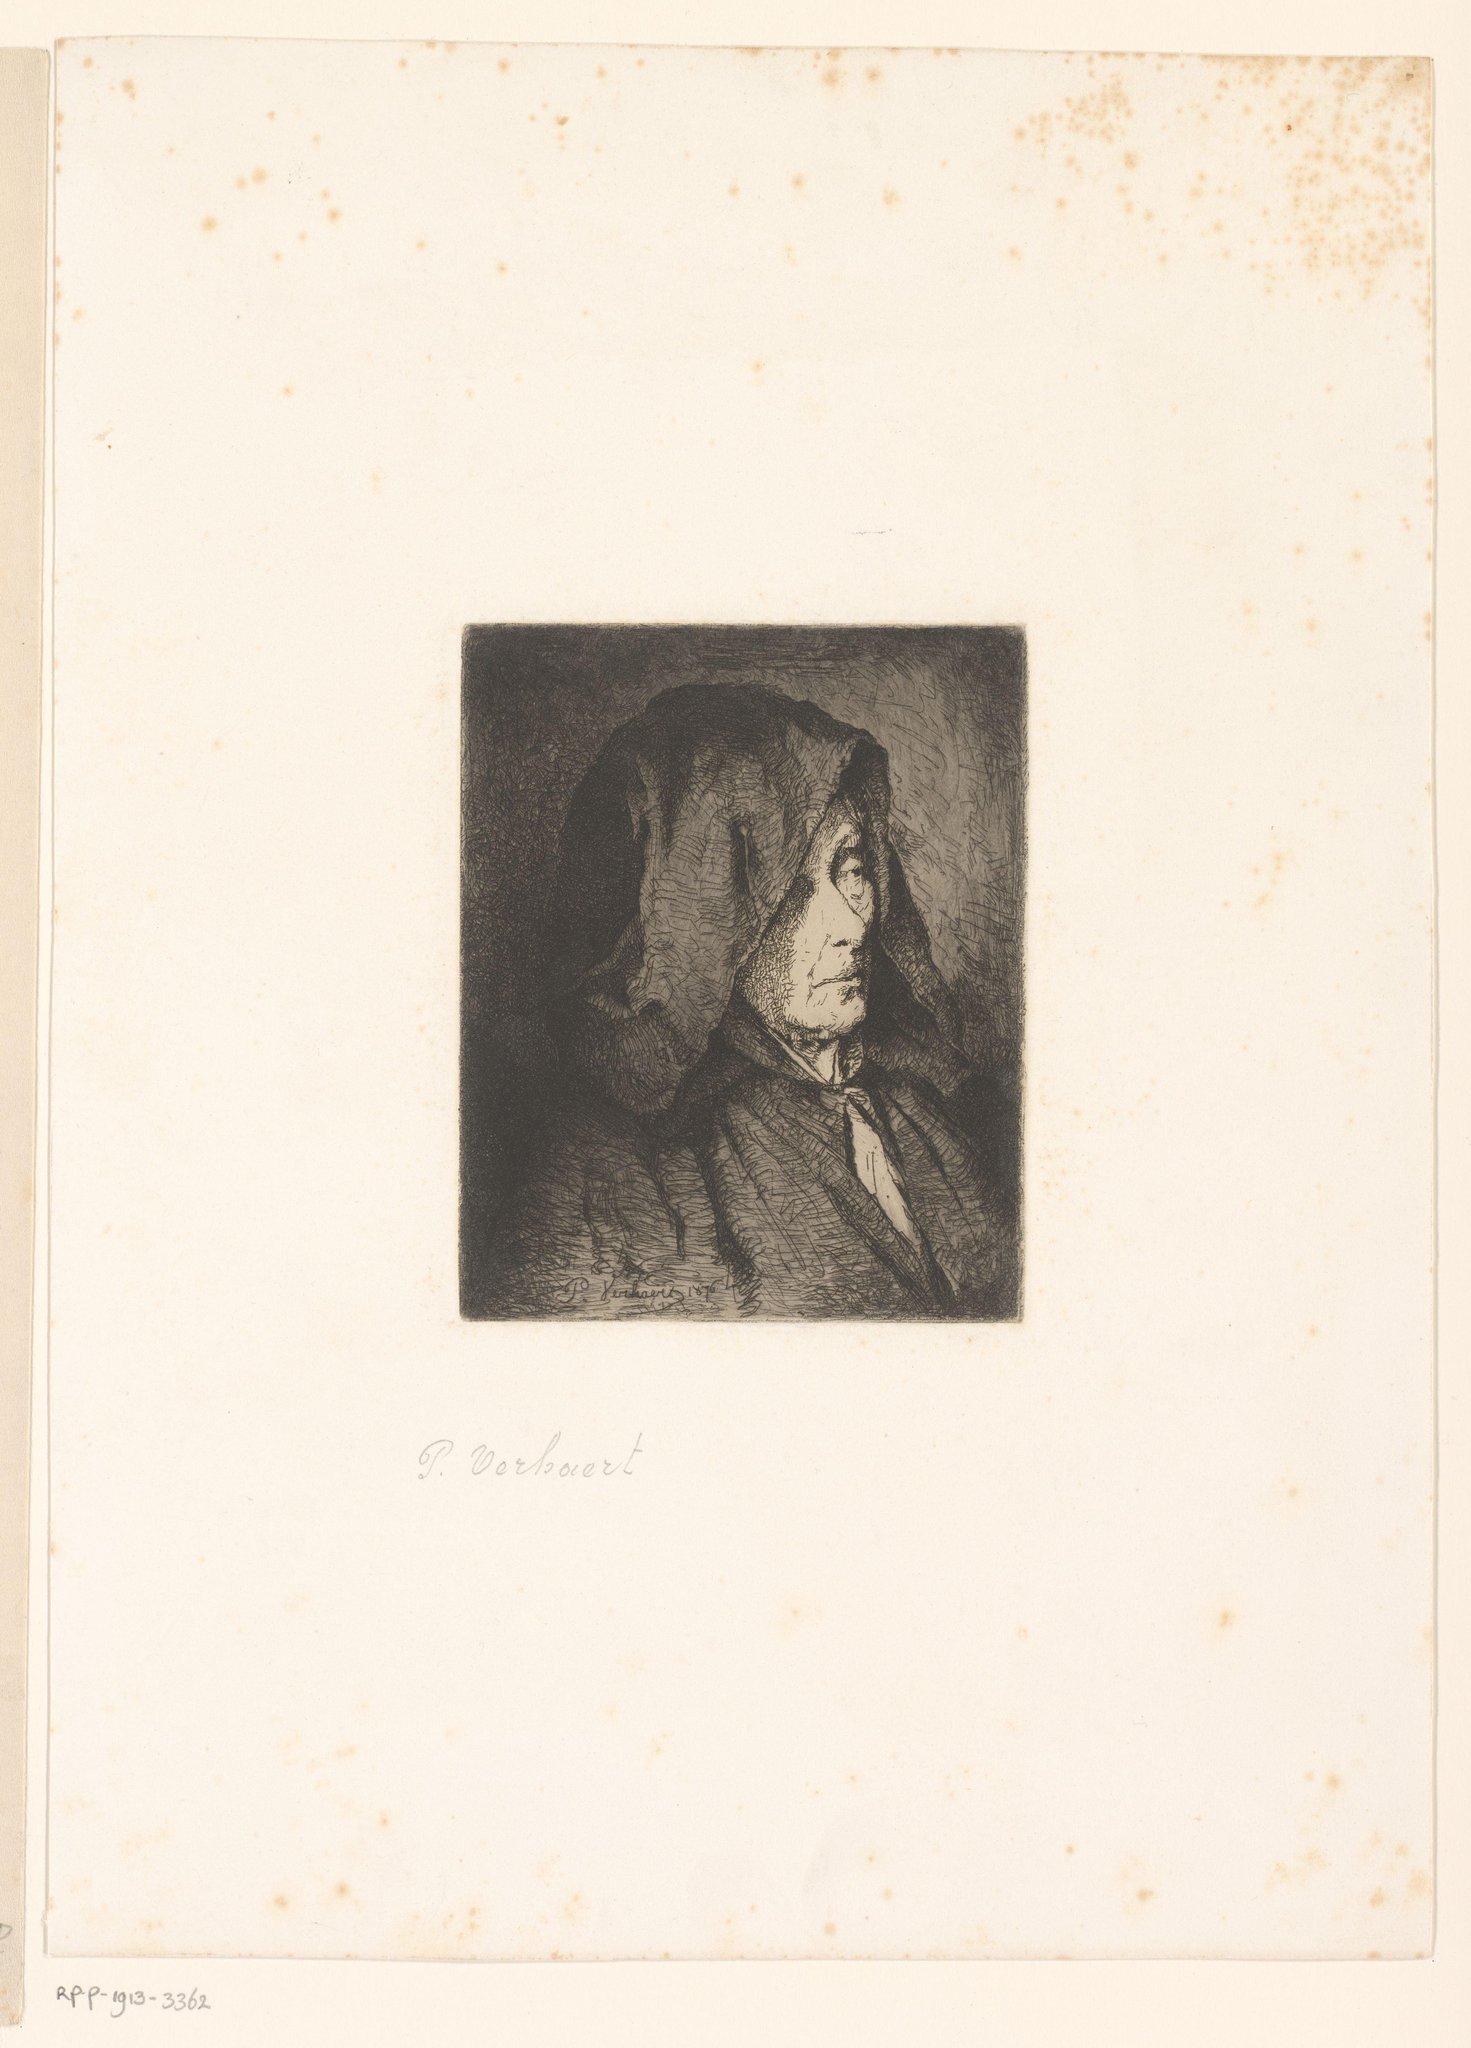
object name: print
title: Hoofd van een oude vrouw met capuchon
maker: piet verhaert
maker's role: print maker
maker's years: 1852-1908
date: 1876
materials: paper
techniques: etching, intaglio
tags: head-gear: hood, old woman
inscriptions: collector's mark: Lugt 2228